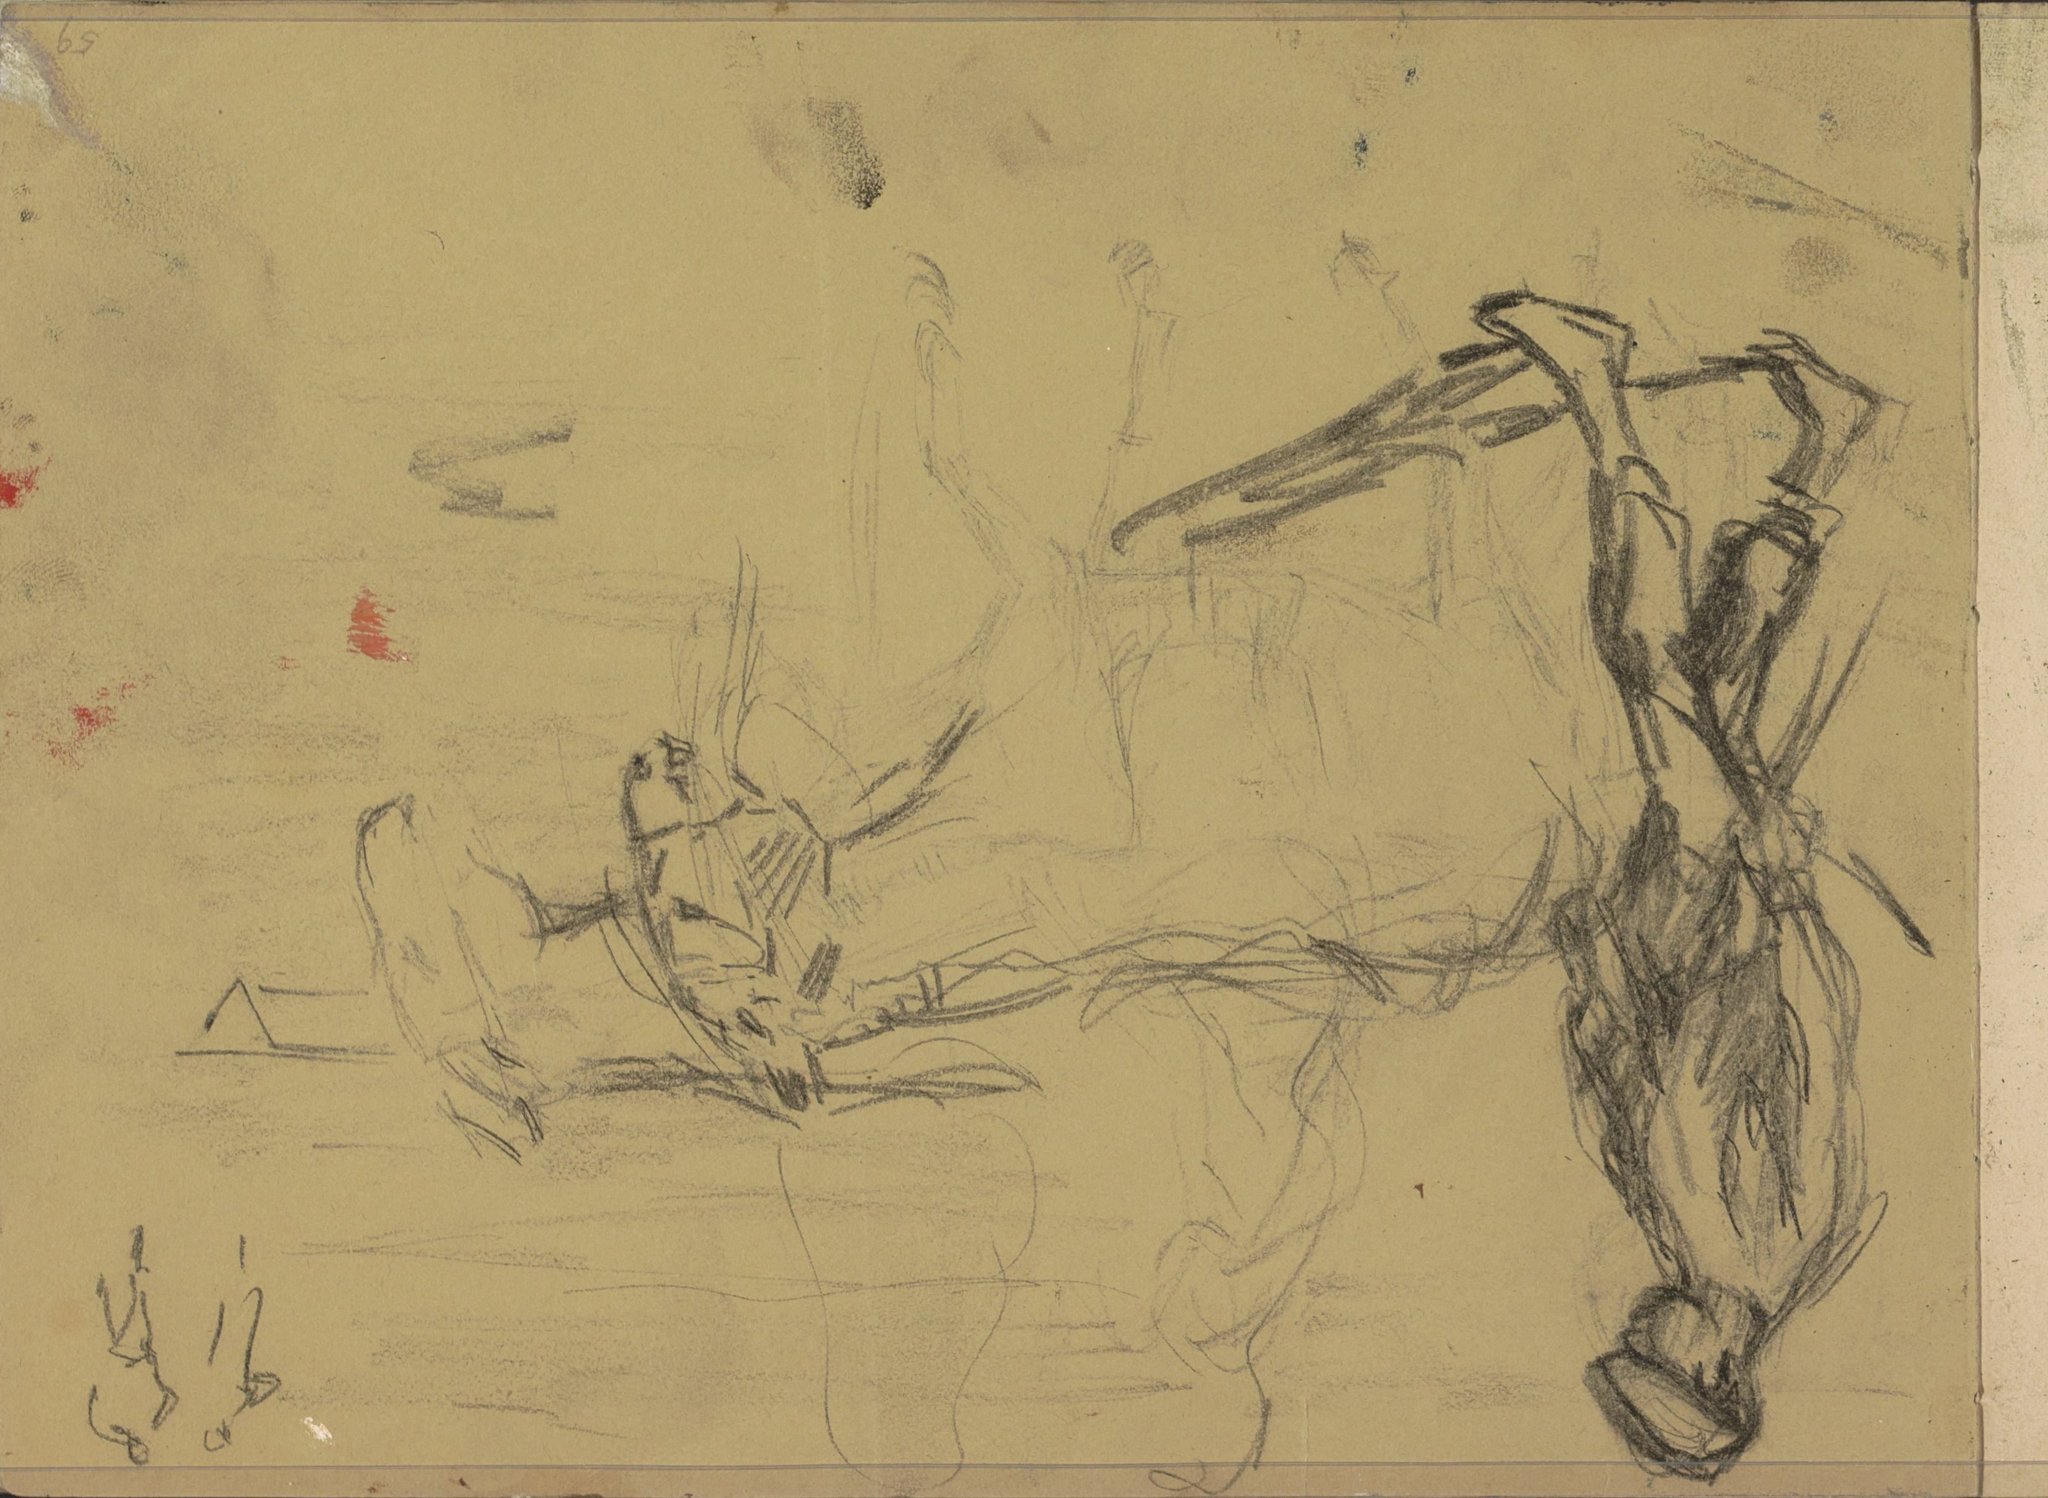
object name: sketchbook leaf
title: Ezelrijden op het strand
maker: isaac israels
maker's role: draughtsman, painter, print maker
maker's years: 1865-1934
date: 1890-1920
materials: chalk, paper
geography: the hague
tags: boy (child between toddler and youth), girl (child between toddler and youth), donkey-riding (on the beach)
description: Een ezeljongen begeleidt twee ezels met meisjes. Blad 28 verso uit schetsboek X met 43 bladen.